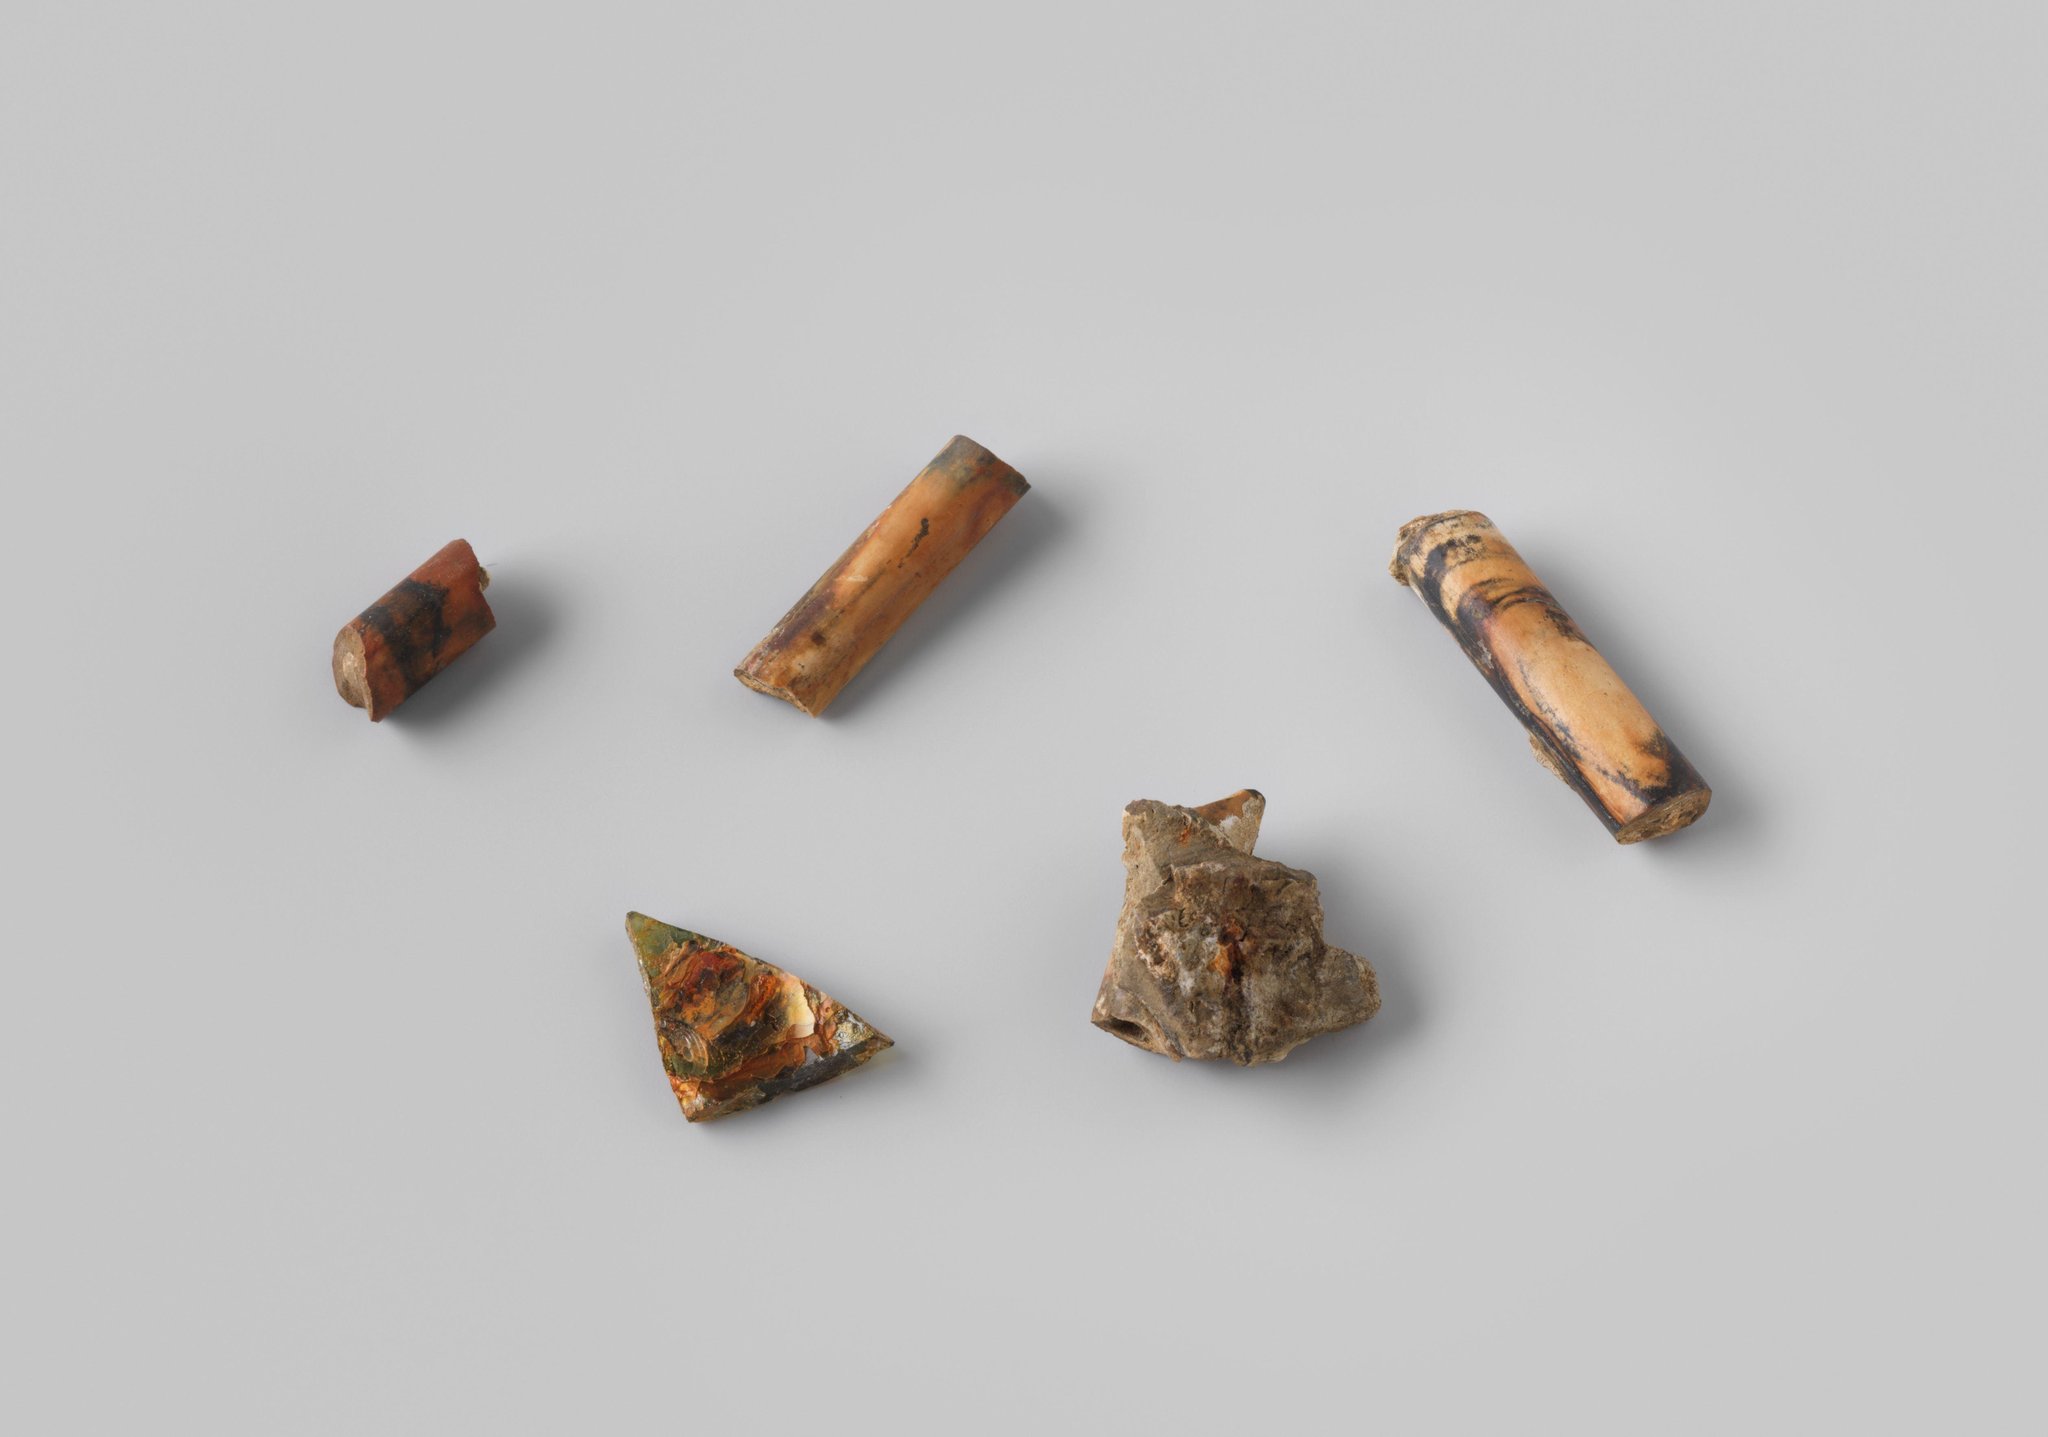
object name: pipe stem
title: Glasscherf en fragmenten pijpensteel uit het wrak van de Oostindiëvaarder 't Vliegend Hart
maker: Anonymous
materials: glass, clay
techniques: green glass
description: Eén glasscherf en vier fragmenten van een pijpensteel, waarvan er één omsloten is door concretie.